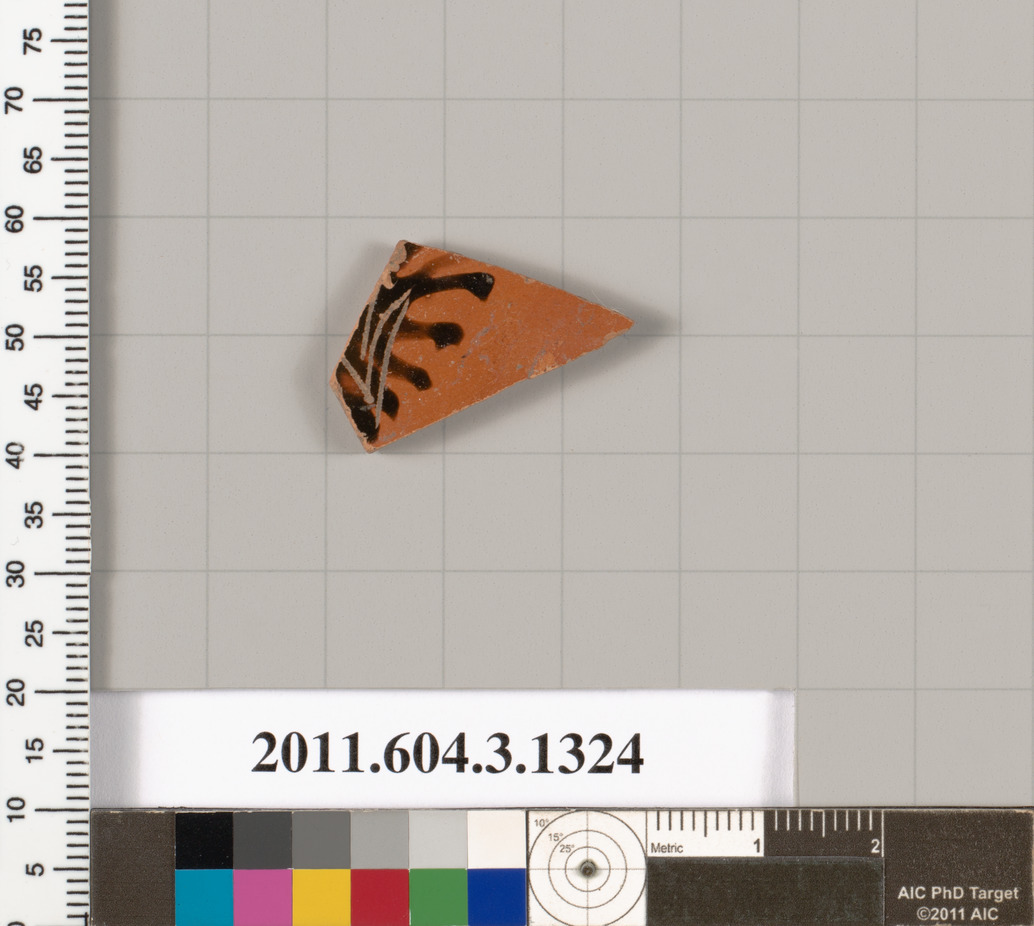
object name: skyphos fragment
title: Terracotta fragment of a skyphos (deep drinking cup)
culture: greek, attic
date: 490-480 BCE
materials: terracotta